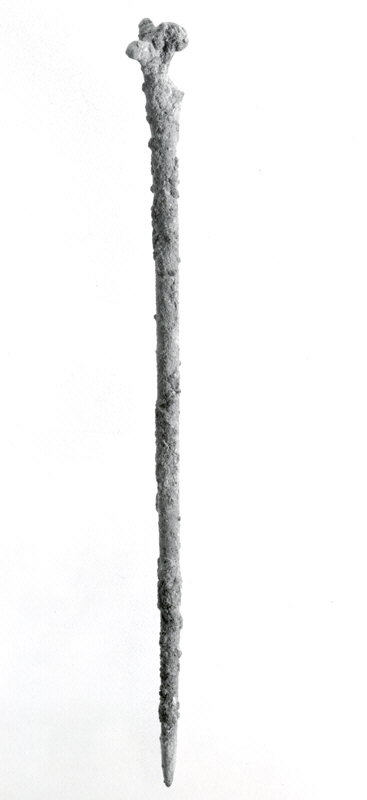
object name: pin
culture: bactria-margiana archaeological complex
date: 2333-1668 BCE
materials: copper alloy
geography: bactria-margiana